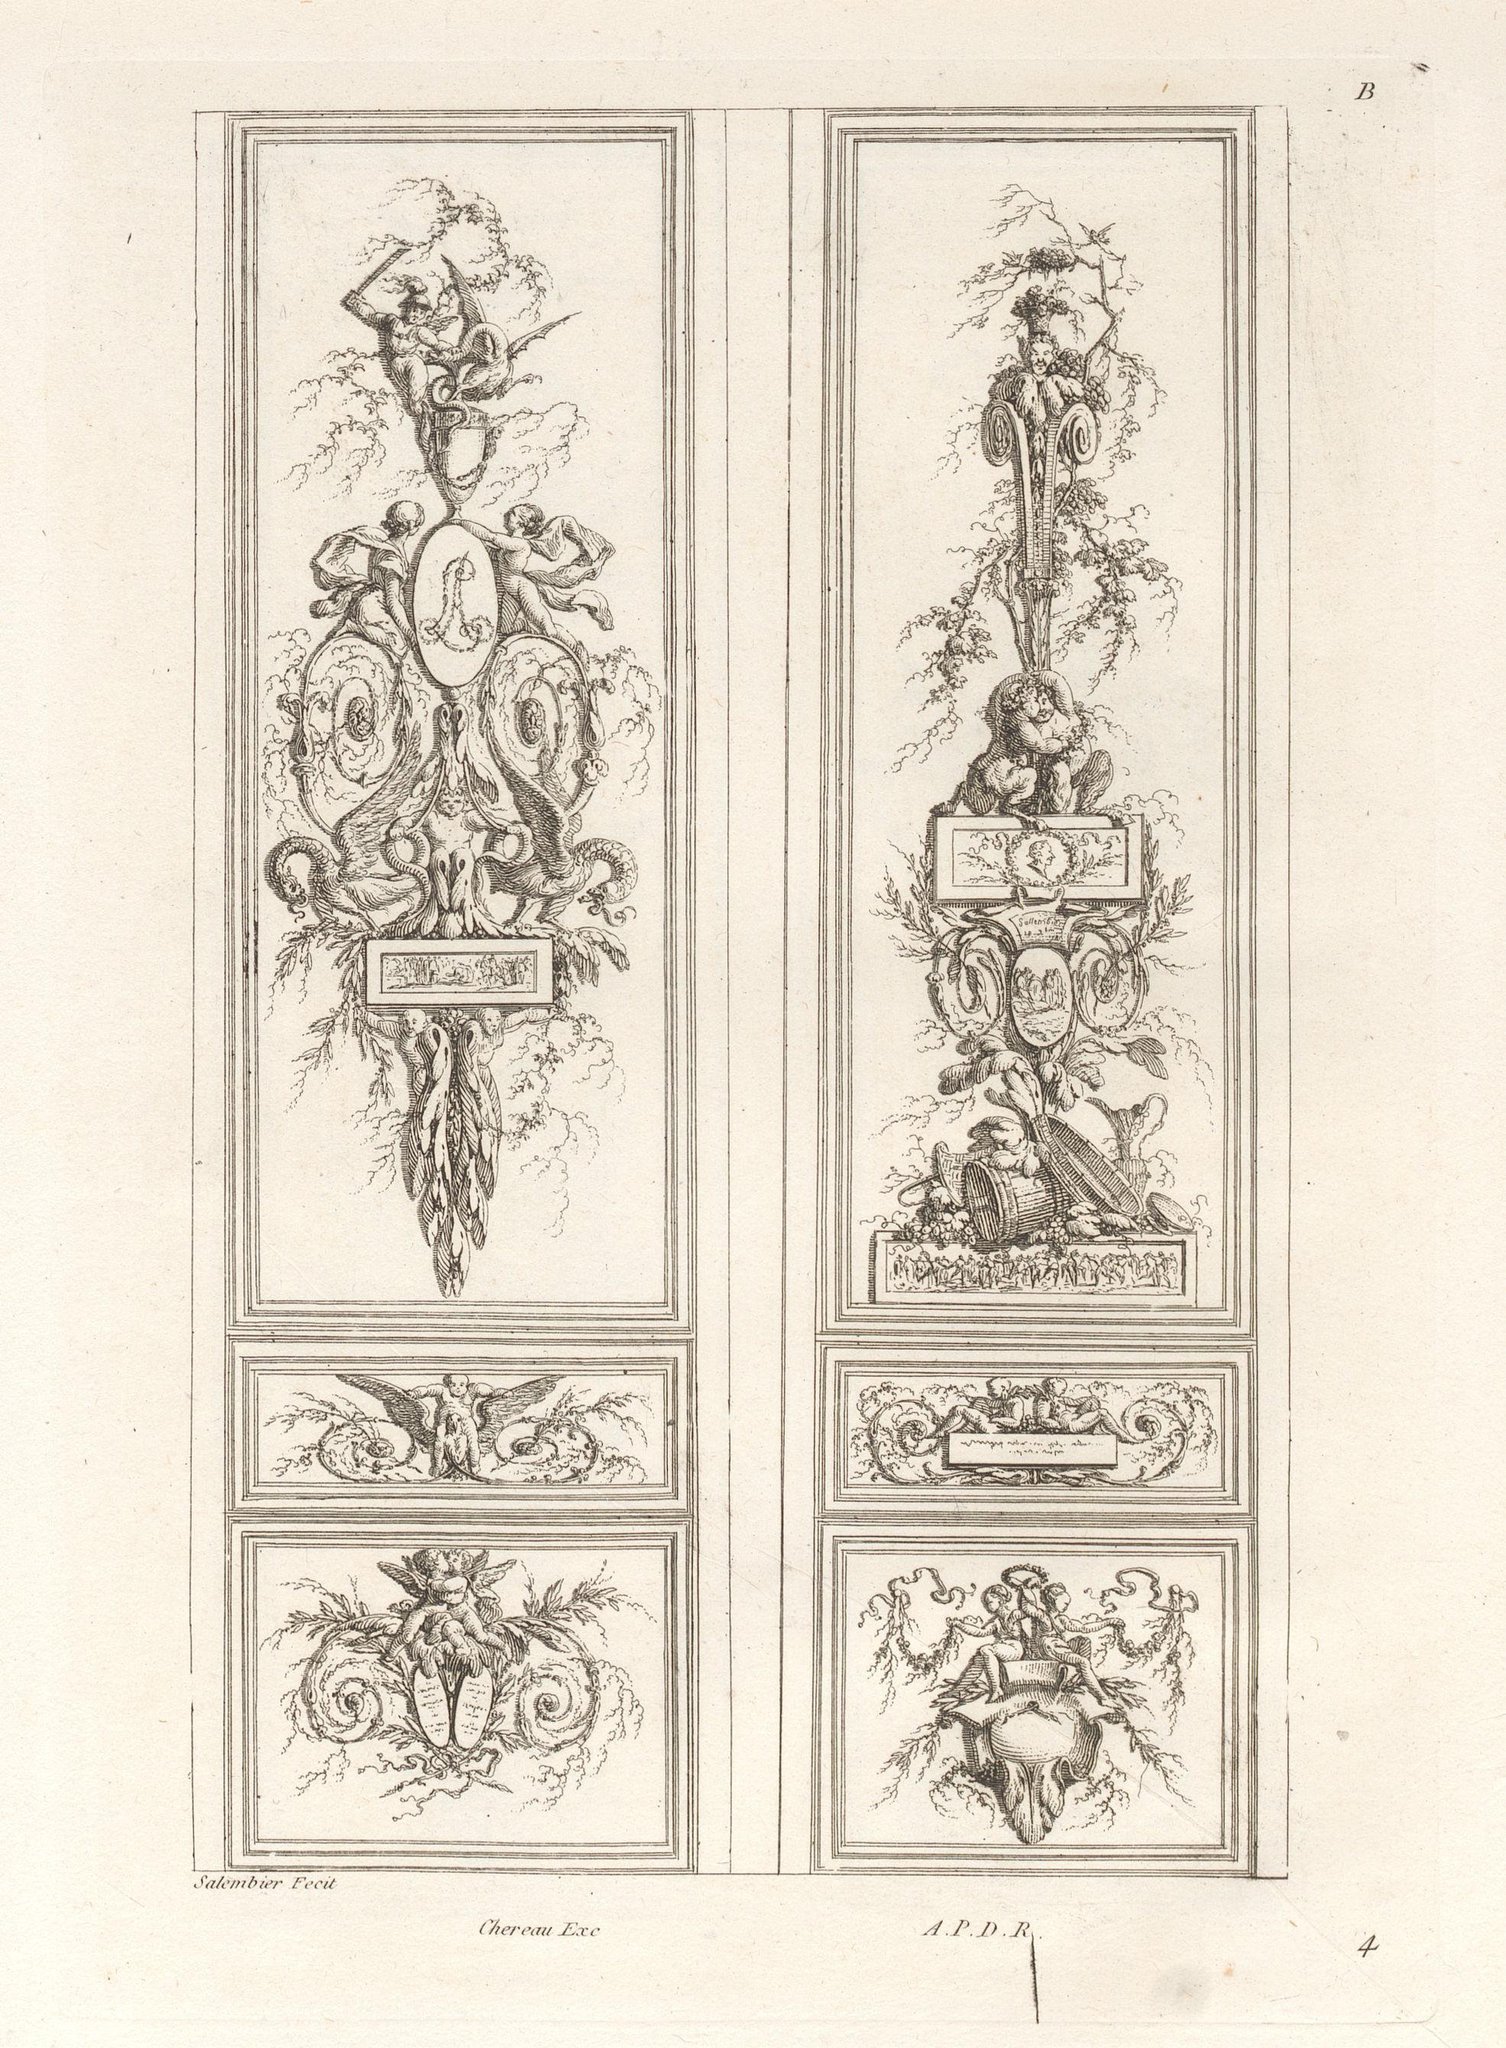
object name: print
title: Twee ontwerpen voor ornamentele wandpanelen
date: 1802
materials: paper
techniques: etching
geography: paris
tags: ornament ~ arabesque, partially clothed - aa - female human figure, drum (musical instrument), satyr(s) (in general), dragon, cupids: 'amores', 'amoretti', 'putti', ornament derived from plant forms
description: Doordat dit album bestaat uit meerdere, deels eerder uitgegeven prentreeksen, is de datering niet consequent. Het geheel is op de titelpagina gedateerd op 1802. Deze reeks is niet afzonderlijk gedateerd. De serietitel voor het gehele werk is "Recueil d'arabesques, contenant les loges du Vatican". De andere serietitel is de titel van de specifieke reeks binnen het geheel.